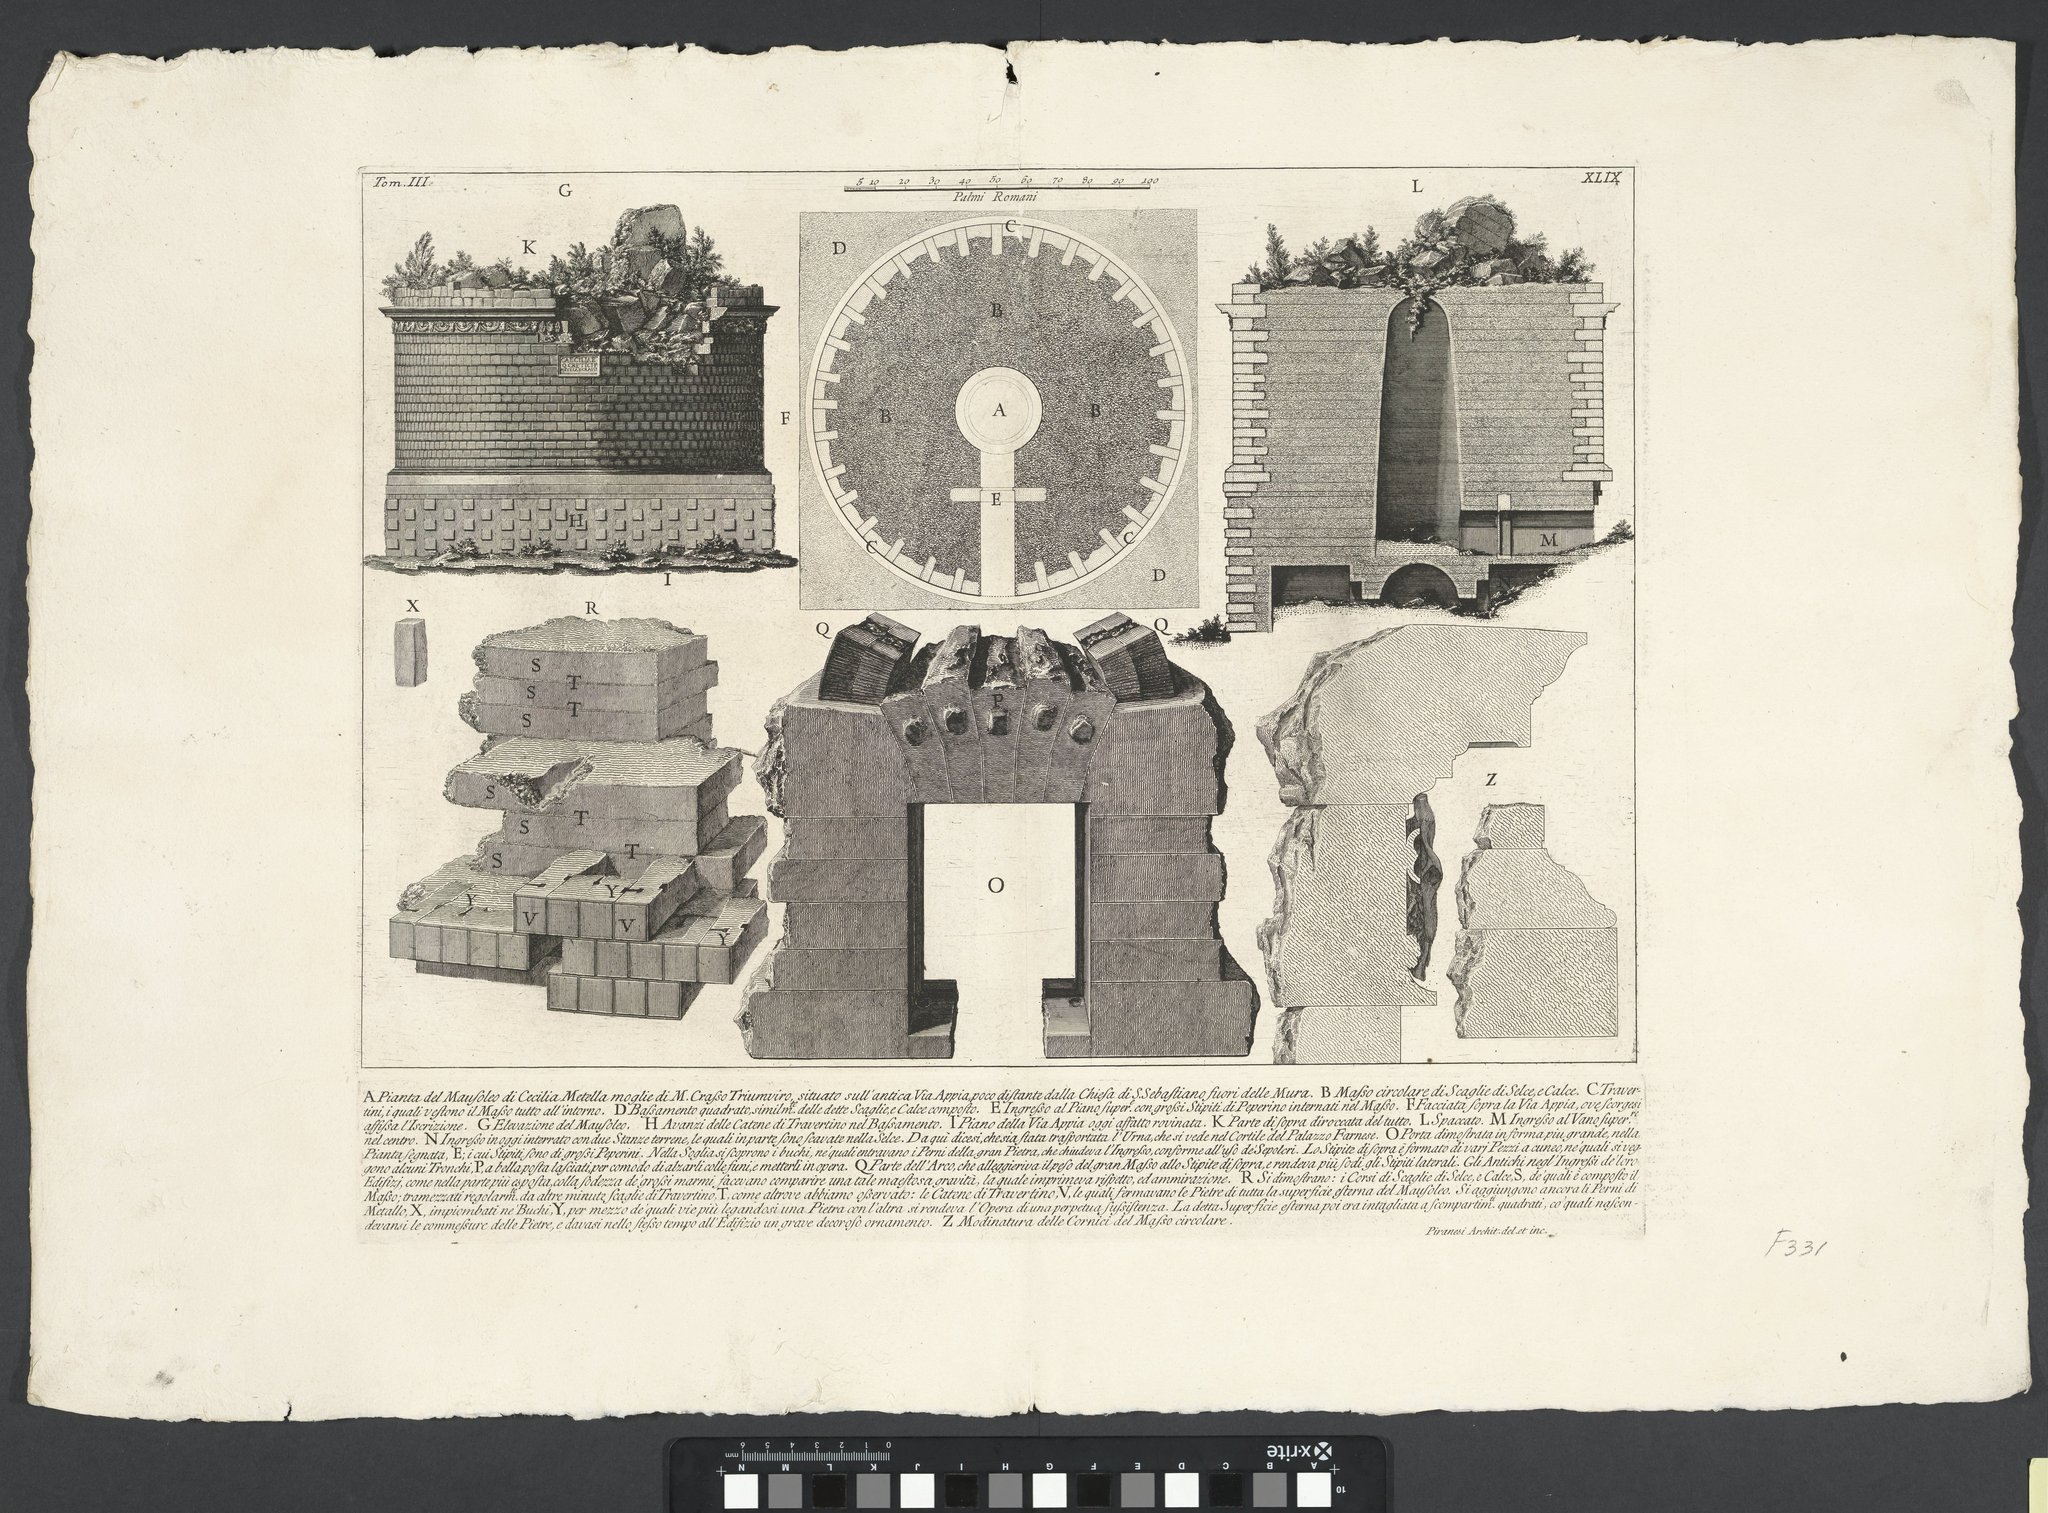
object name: print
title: Le Antichità Romane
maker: giovanni battista piranesi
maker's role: designer, draughtsman, print maker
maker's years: 1720-1778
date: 1756-1757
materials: paper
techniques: etching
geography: rome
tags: grave, tomb, plan ~ architecture, rome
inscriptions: collector's mark: Lugt 2228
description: Deze prent maakt deel uit van de serie 'Le Antichità Romane'. Piranesi deed meer dan acht jaar voorstudie voor deze 250 platen tellende serie die in vier volumes werd uitgegeven. Hij produceerde de prenten tussen ca. 1756 en 1757. De serie bevat ook prenten door of naar andere prentmakers, onder wie Francesco Bianchini en Girolamo Rossi.